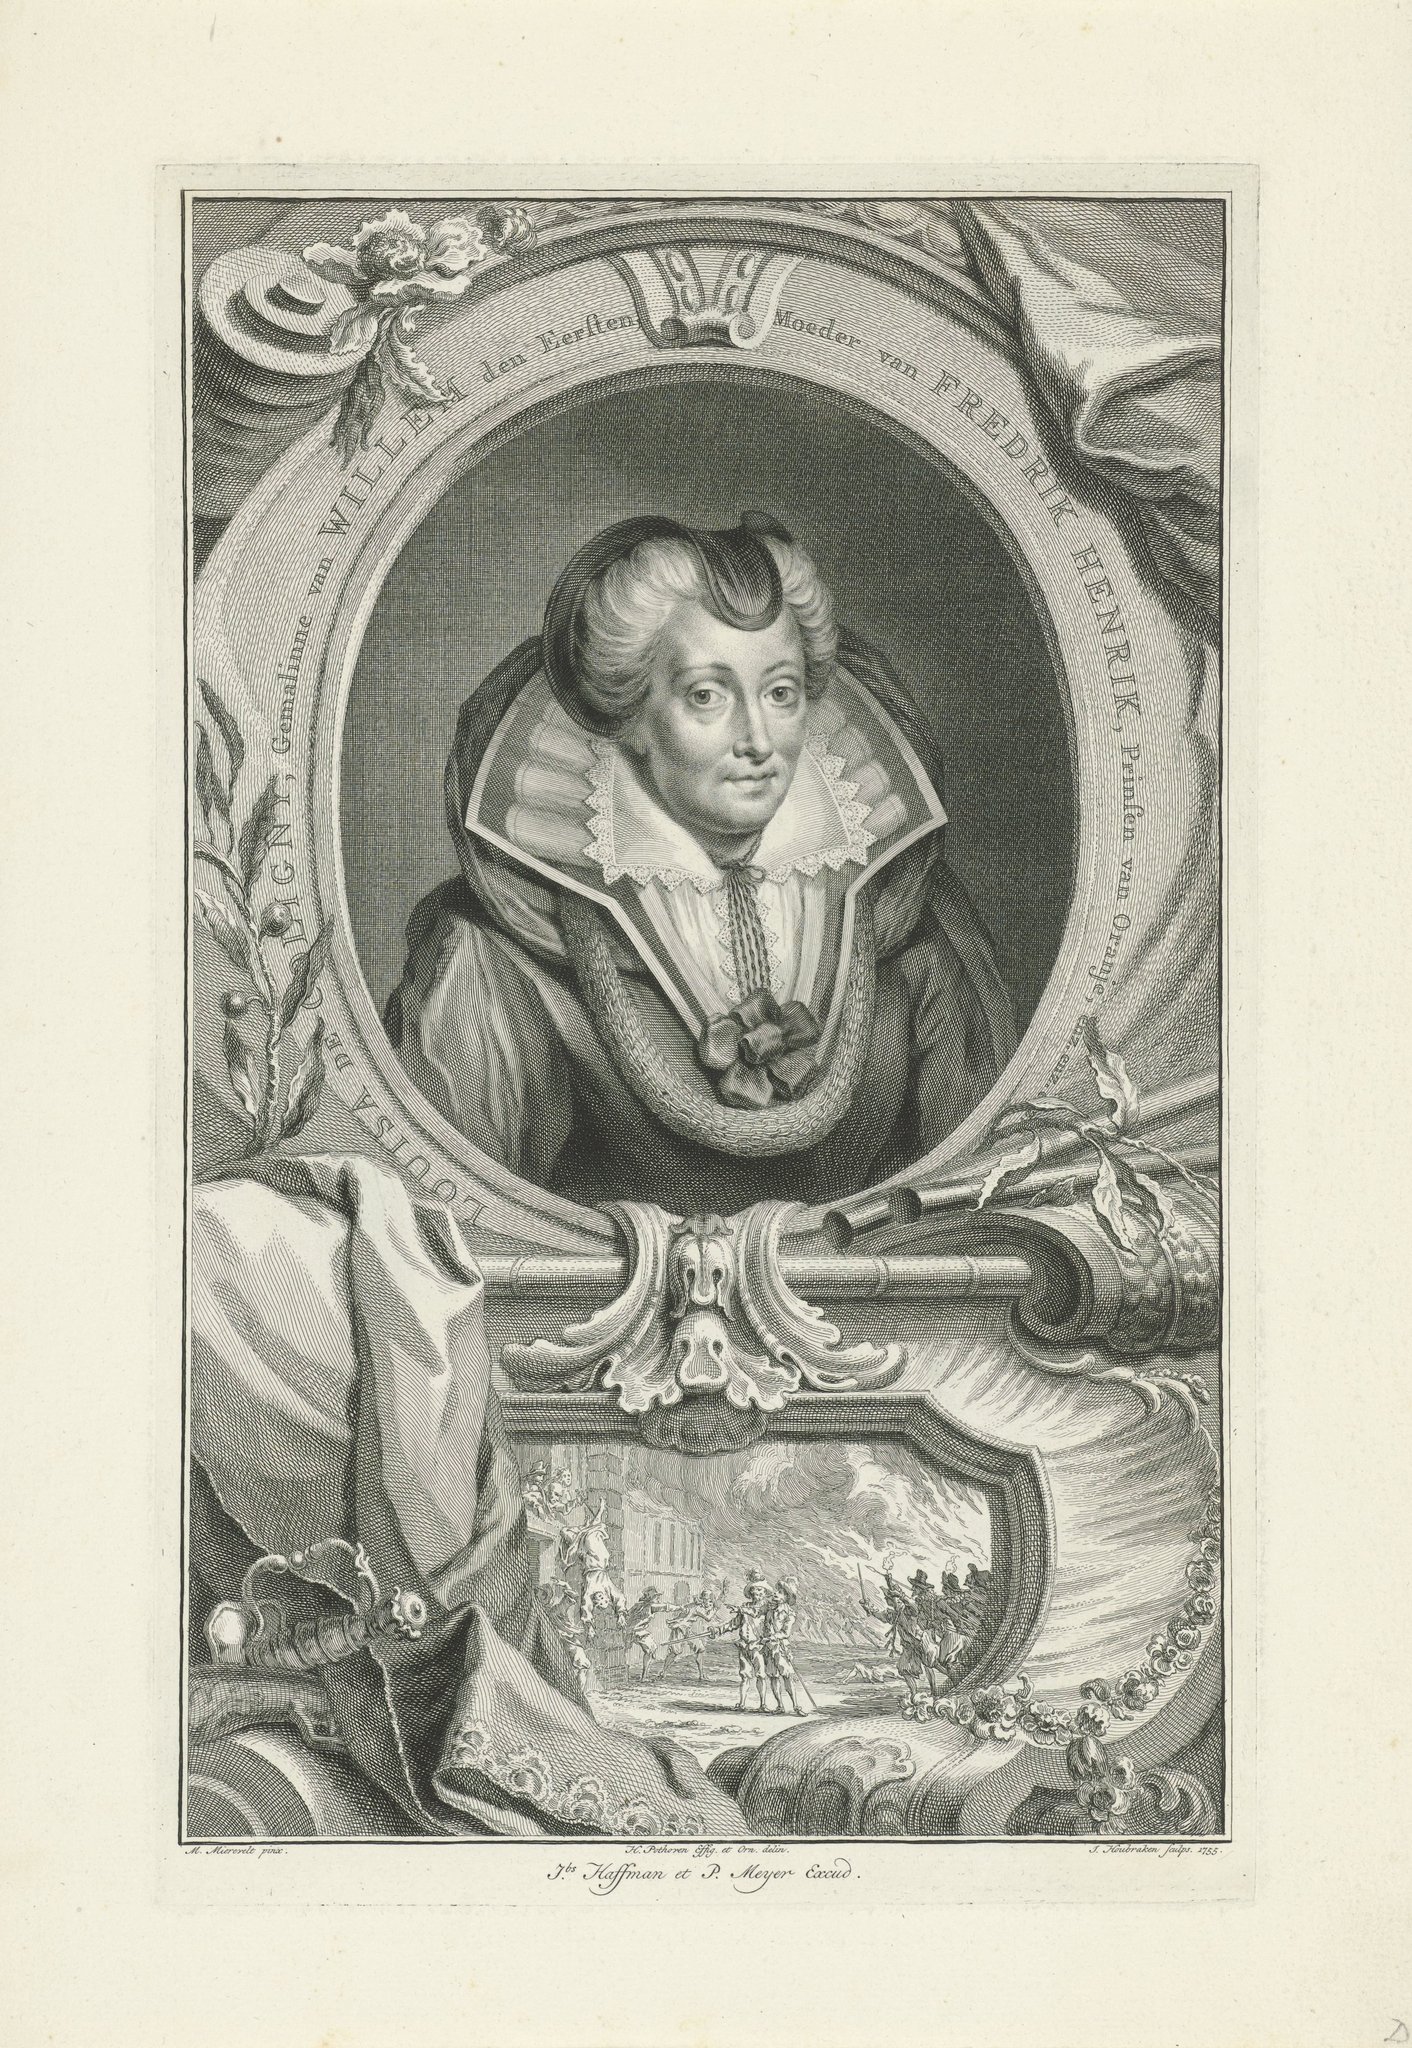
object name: print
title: Portret van Louise de Coligny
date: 1755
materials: paper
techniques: engraving, etching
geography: amsterdam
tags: louise de coligny, neck-gear: collar (+ women's clothes)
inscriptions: collector's mark: Lugt 2228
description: Portret van Louise de Coligny, vierde echtgenote van Willem I, Prins van Oranje. Zesde prent uit een serie van zes met de afbeeldingen van de gemalinnen en moeders van de stadhouders.